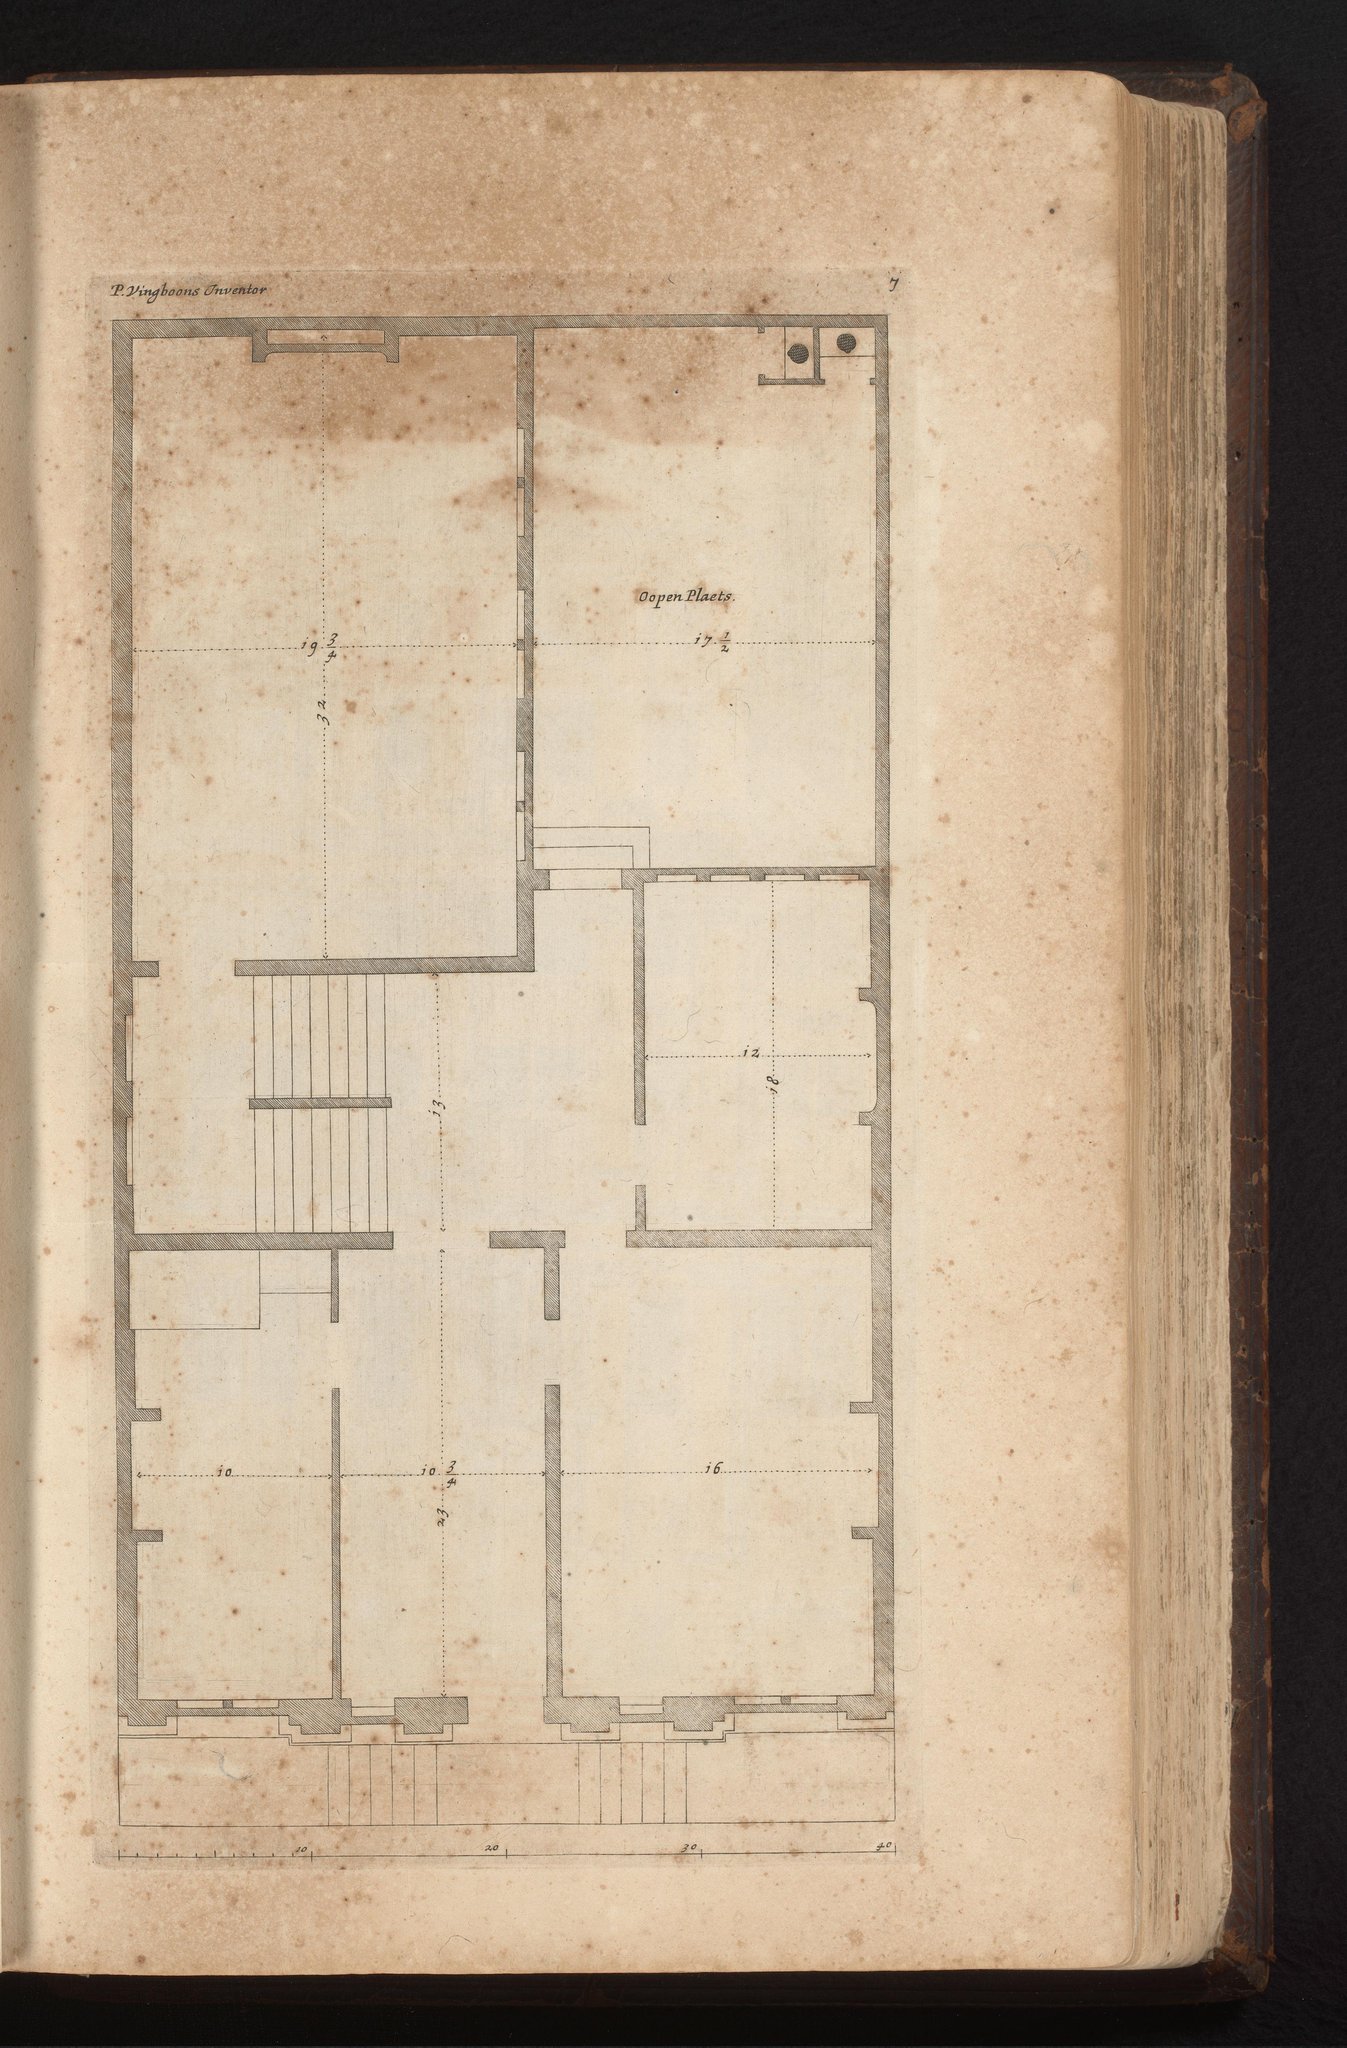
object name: book illustration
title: Plattegrond voor een herenhuis aan de Herengracht te Amsterdam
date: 1648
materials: paper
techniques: engraving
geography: amsterdam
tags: plan ~ architecture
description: Prent uit: Afbeelsels der voornaemste gebouwen uyt alle die Philips Vingboons geordineert heeft. Amsterdam: Philips en Johannes Vinckboons en Johannes Willemszoon Blaeu, 1648.